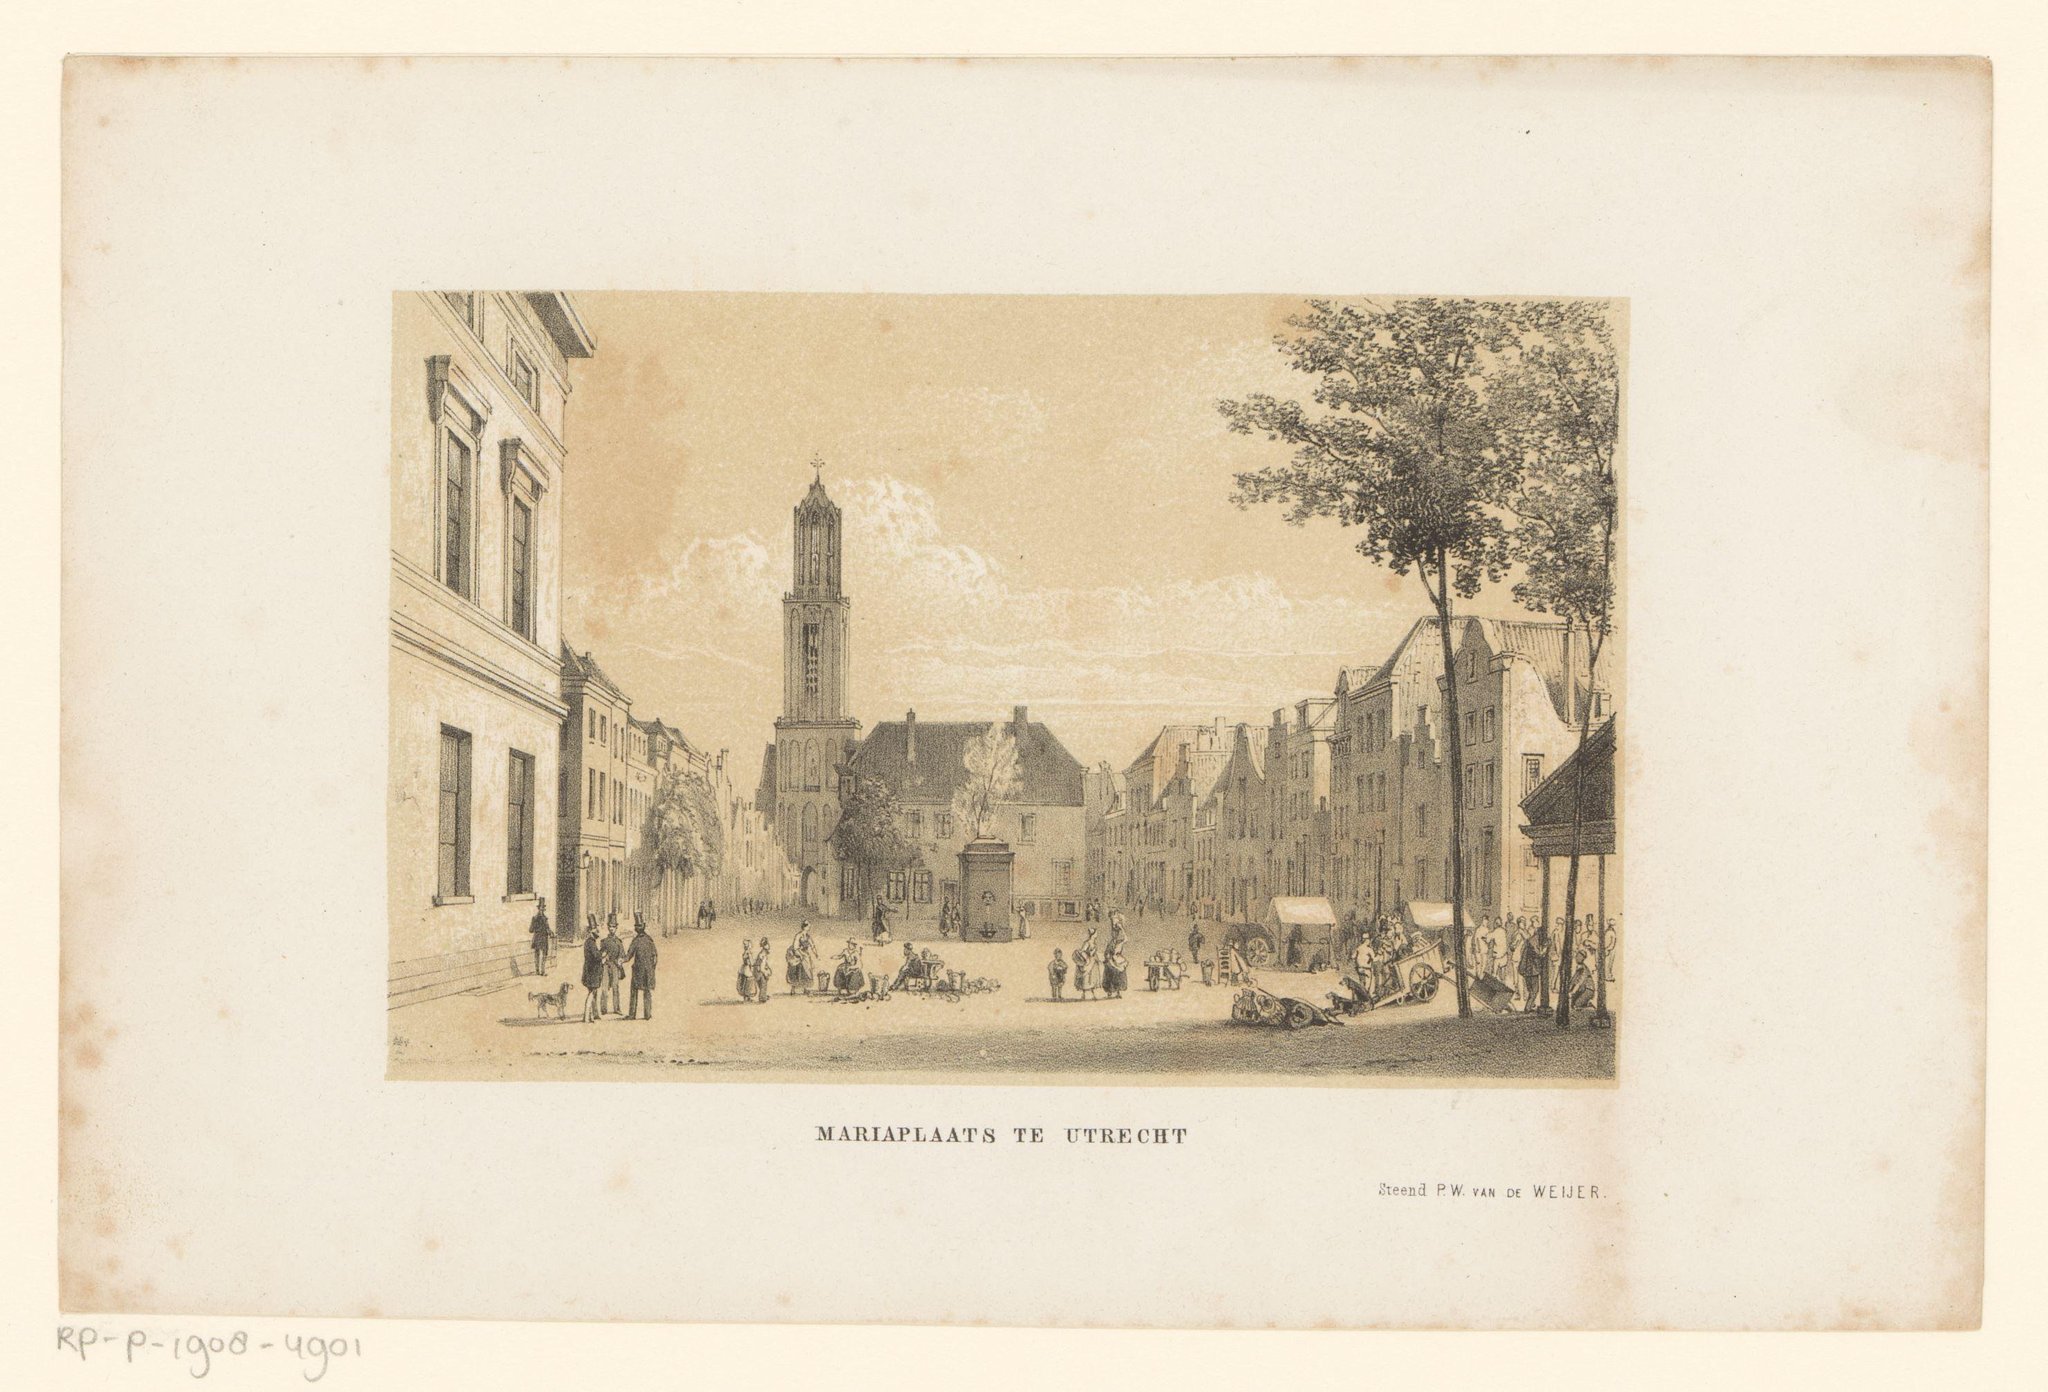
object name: print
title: Mariaplaats te Utrecht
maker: pieter wilhelmus van de weijer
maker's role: print maker, printer, publisher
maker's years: 1816-1880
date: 1856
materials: paper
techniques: tone lithography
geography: utrecht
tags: city-view, and landscape with man-made constructions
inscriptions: collector's mark: Lugt 2228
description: Blik op de Mariaplaats vanuit het westen met links de Domtoren. Links gevel van het gebouw voor Kunsten en Wetenschappen gedeeltelijk.